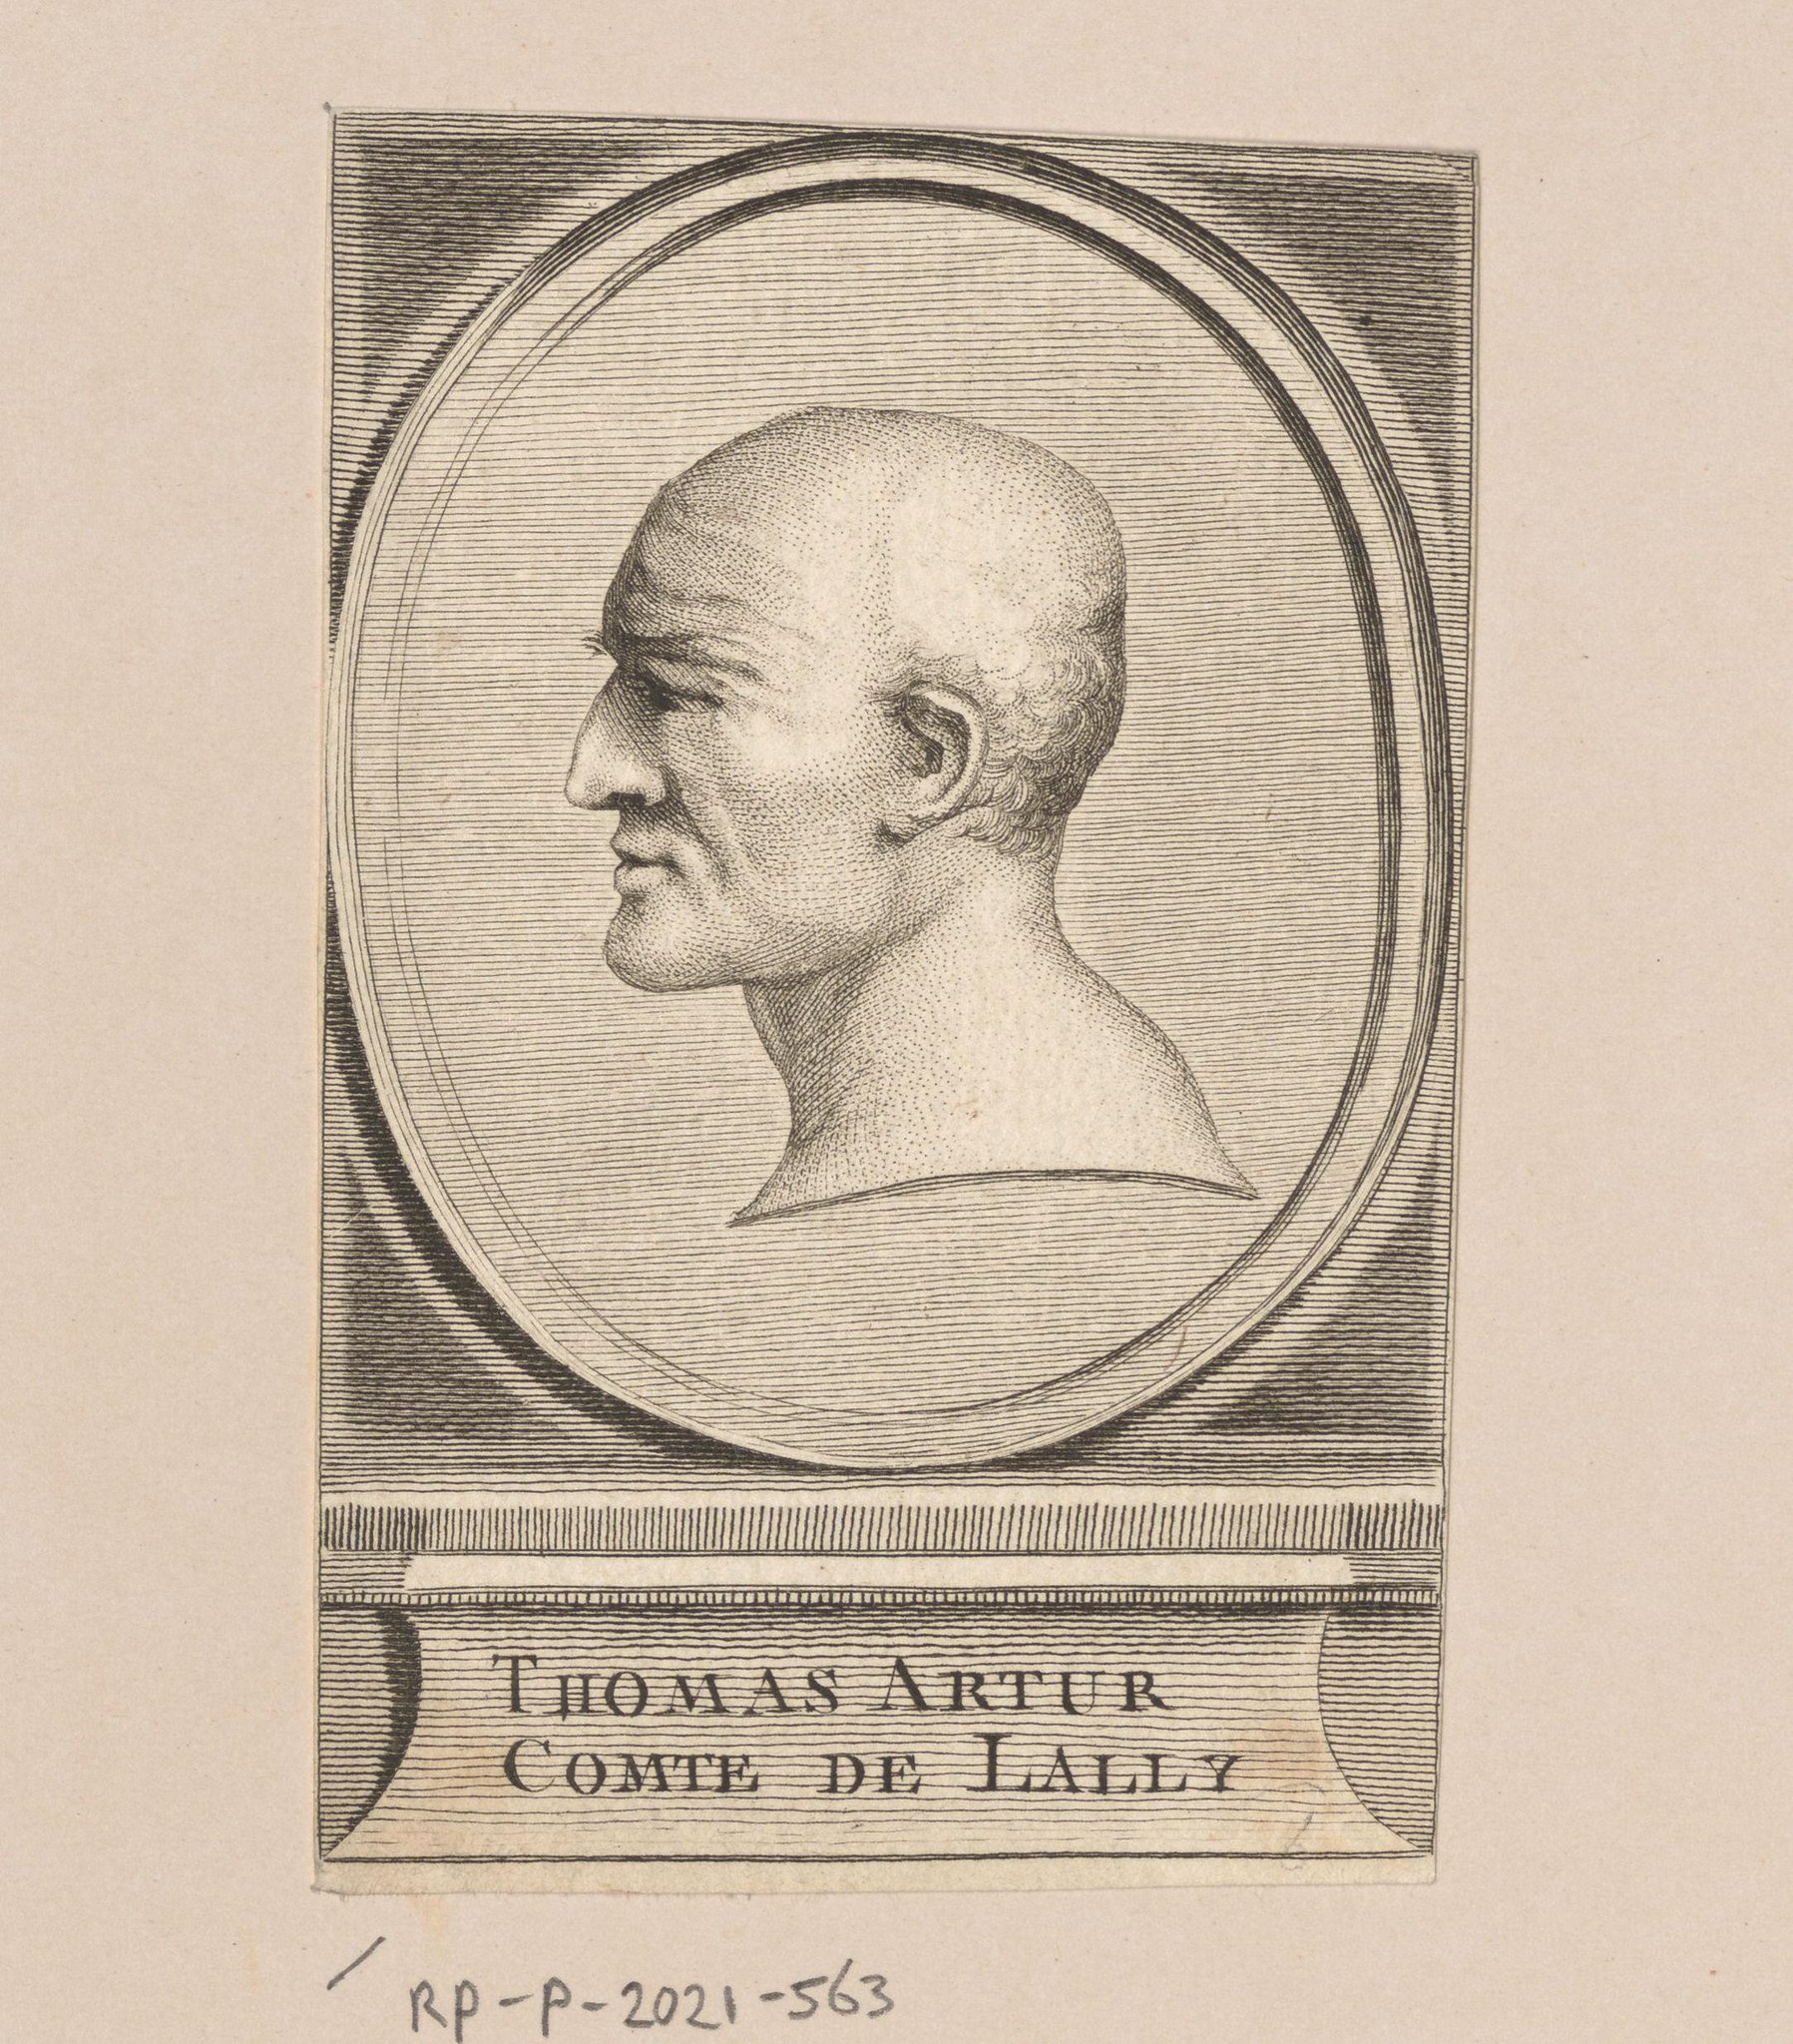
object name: print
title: Portretbuste van Thomas Arthur de Lally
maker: Anonymous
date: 1760-1799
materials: paper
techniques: etching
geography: france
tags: paris, historical persons